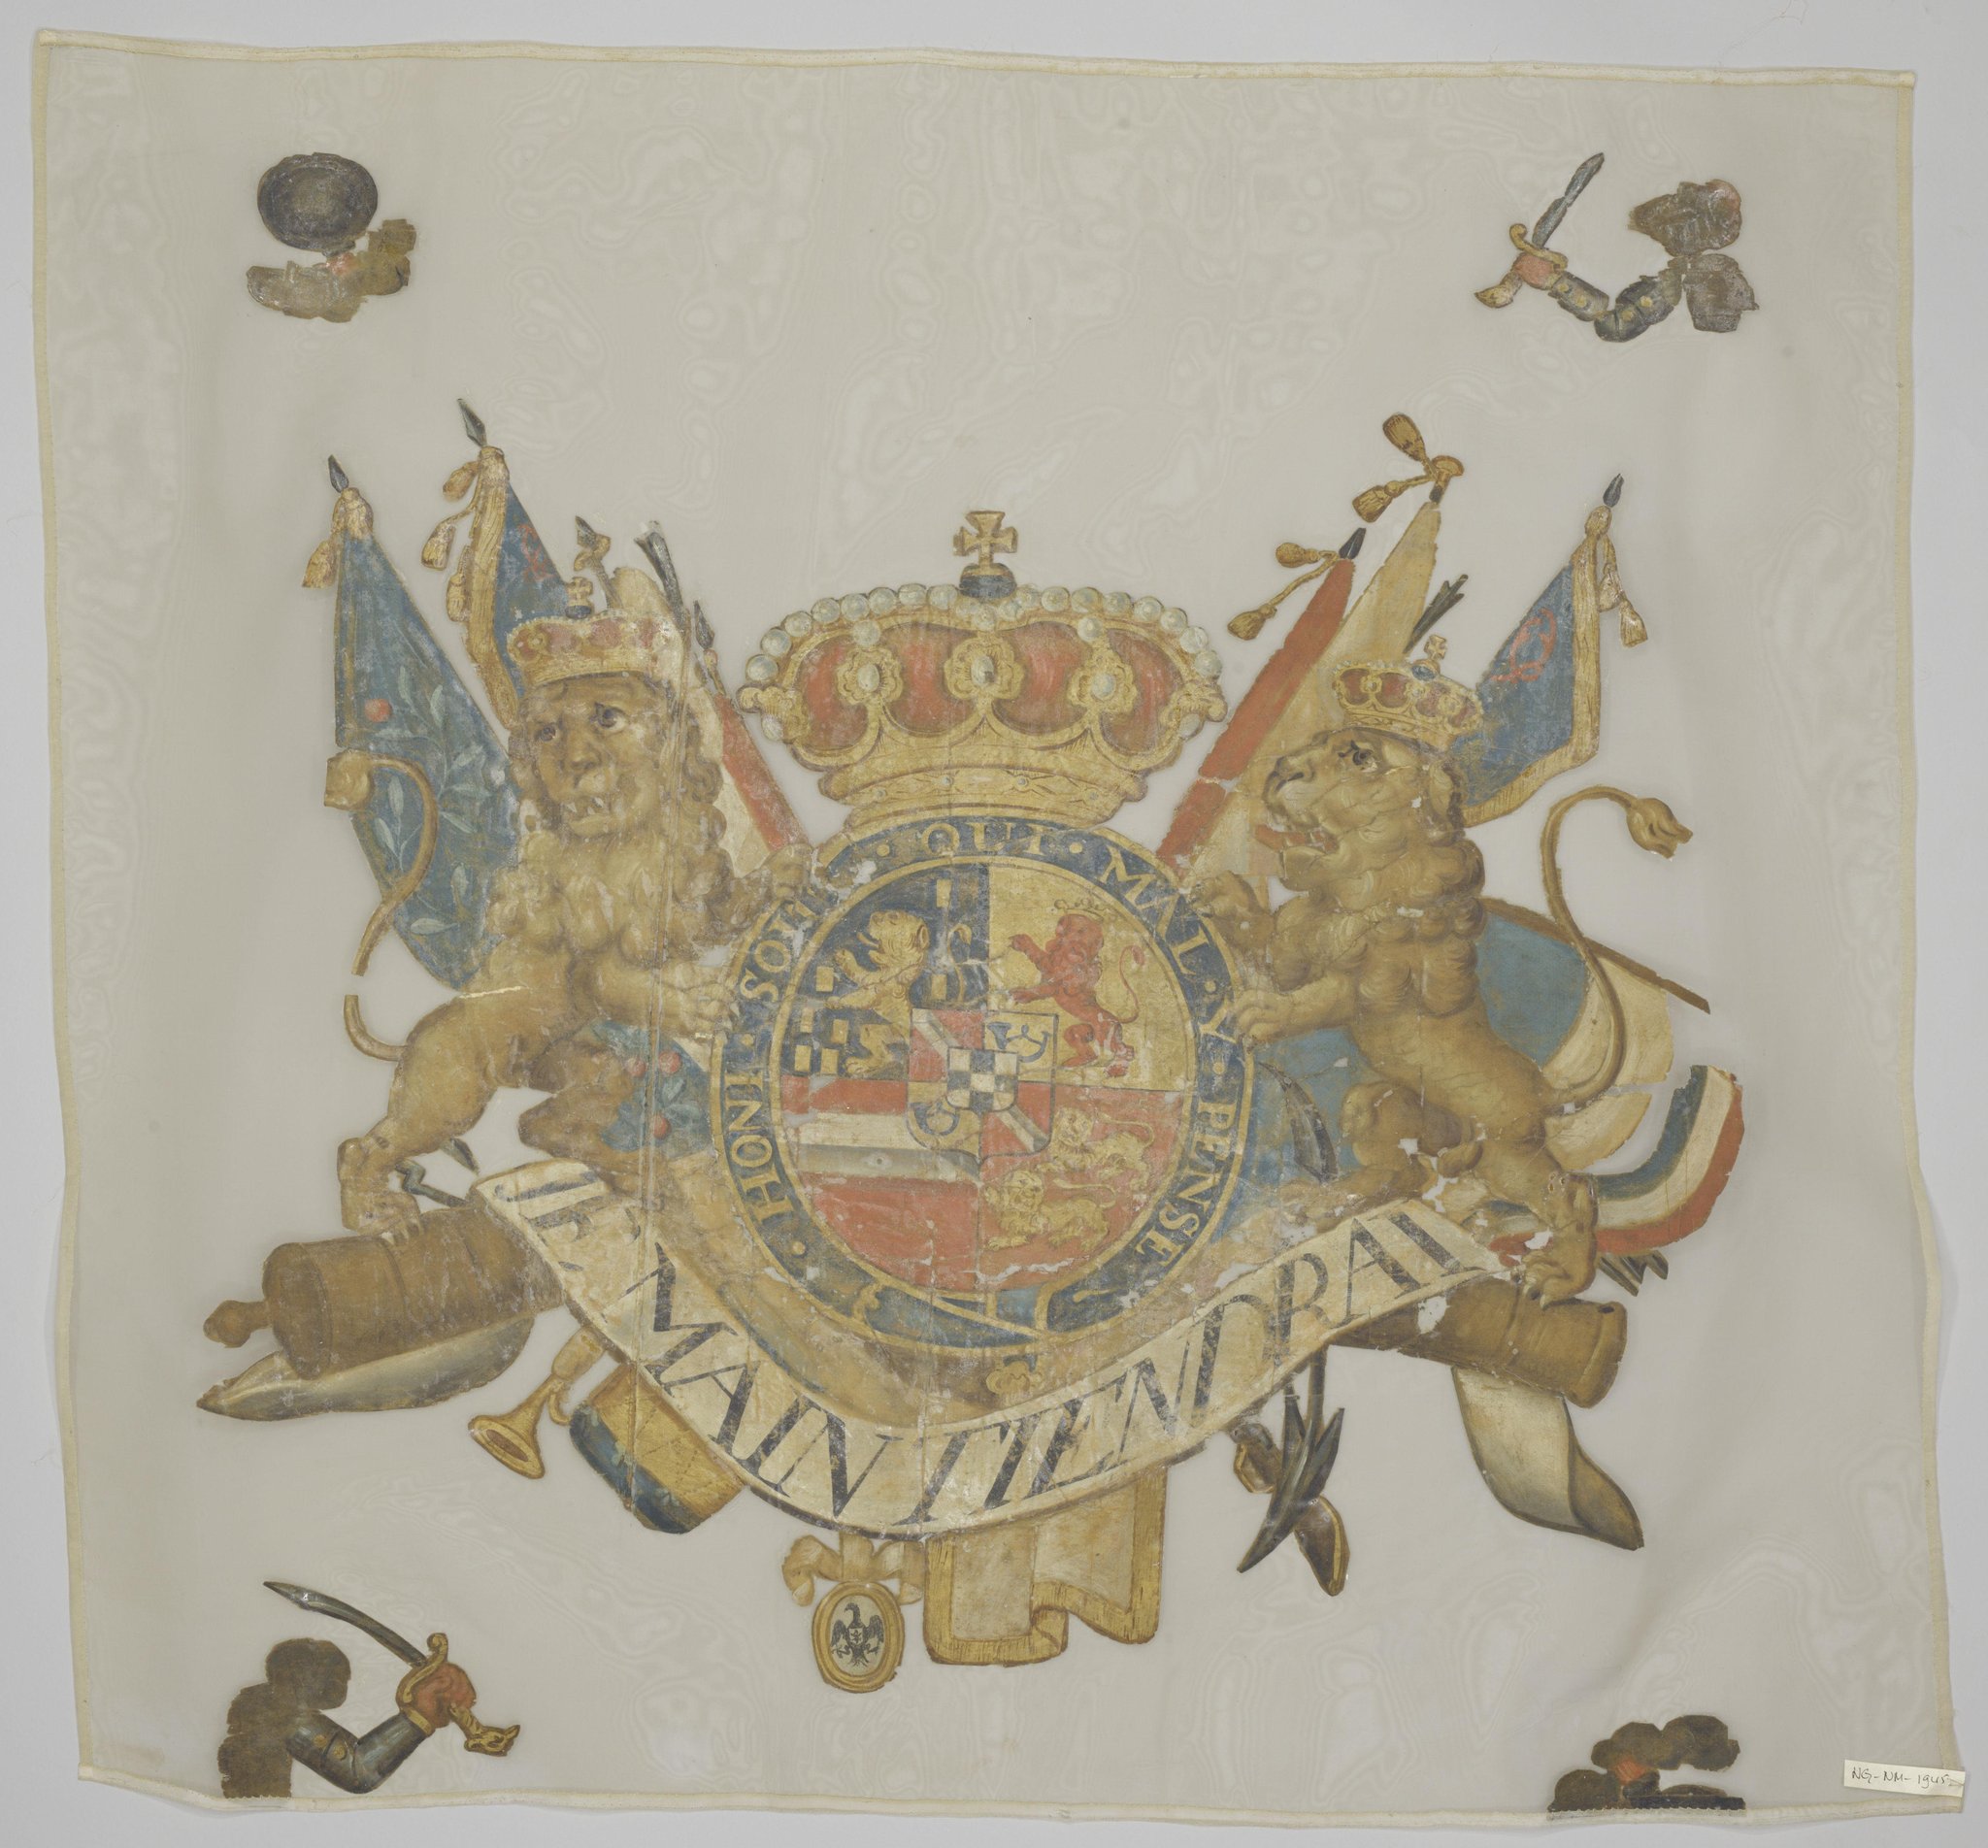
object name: banner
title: Vaandel van het regiment van de Hollandse Gardes te voet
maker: Anonymous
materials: silk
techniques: lining, painted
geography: netherlands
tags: holland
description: Ecru, op het midden een ovaal wapenschild met het volledige wapen van Oranje-Nassau omgeven door de Orde van de Kousenband, gehouden door twee leeuwen waarvan die aan stokzijde afgewend, met koningskroon op, en gedekt door een koningskroon. De leeuwen staan op een witte banderol, waarop in zwarte klassieke kapitalen: JE MAINTIENDRAI. Het geheel is geplaatst op een trofee van vaandels, trompetten, trommels, kanonnen enz. Onderaan hangt aan een wit lint het juweel van de Orde van de Zwarte Adelaar van Pruisen. Opschrift op het wapen: HONI SOIT QUI MAL Y PENSE. In de onderhoek aan stokzijde en de vluchttop een geharnaste arm met gouden kromzwaard; in de bovenhals en vluchthoek een schuin geplaatste granaat. Paradekant identiek.